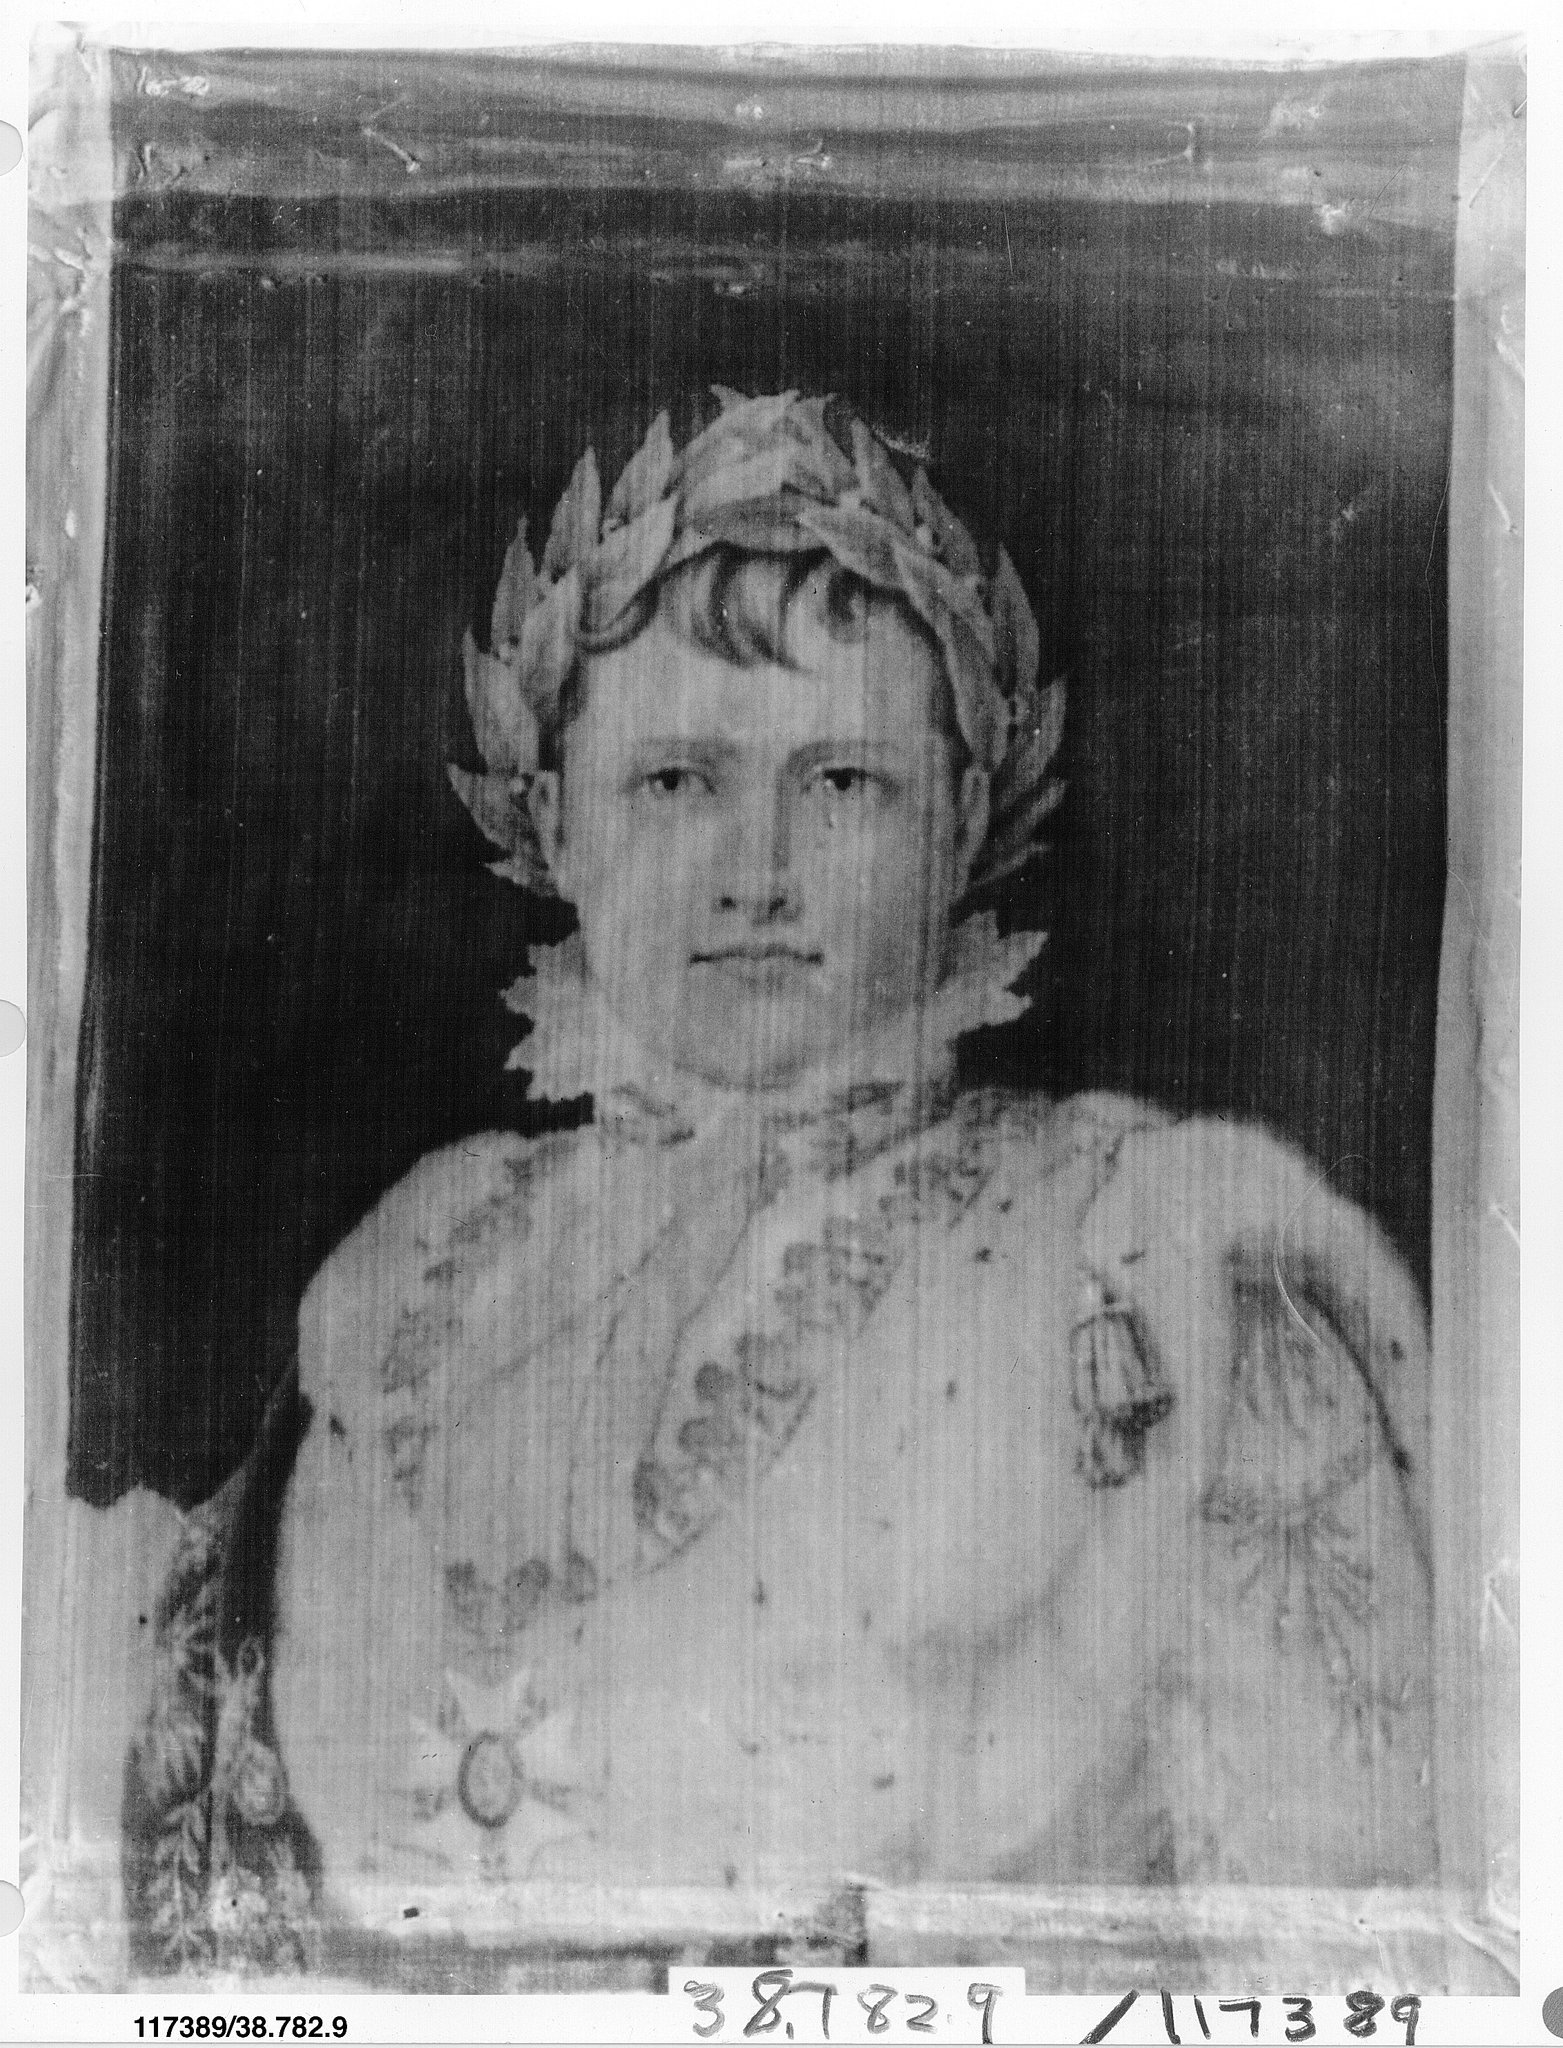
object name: panel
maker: gaspard grégoire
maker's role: designer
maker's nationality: french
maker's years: 1751-1846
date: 1801-1833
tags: men,portraits